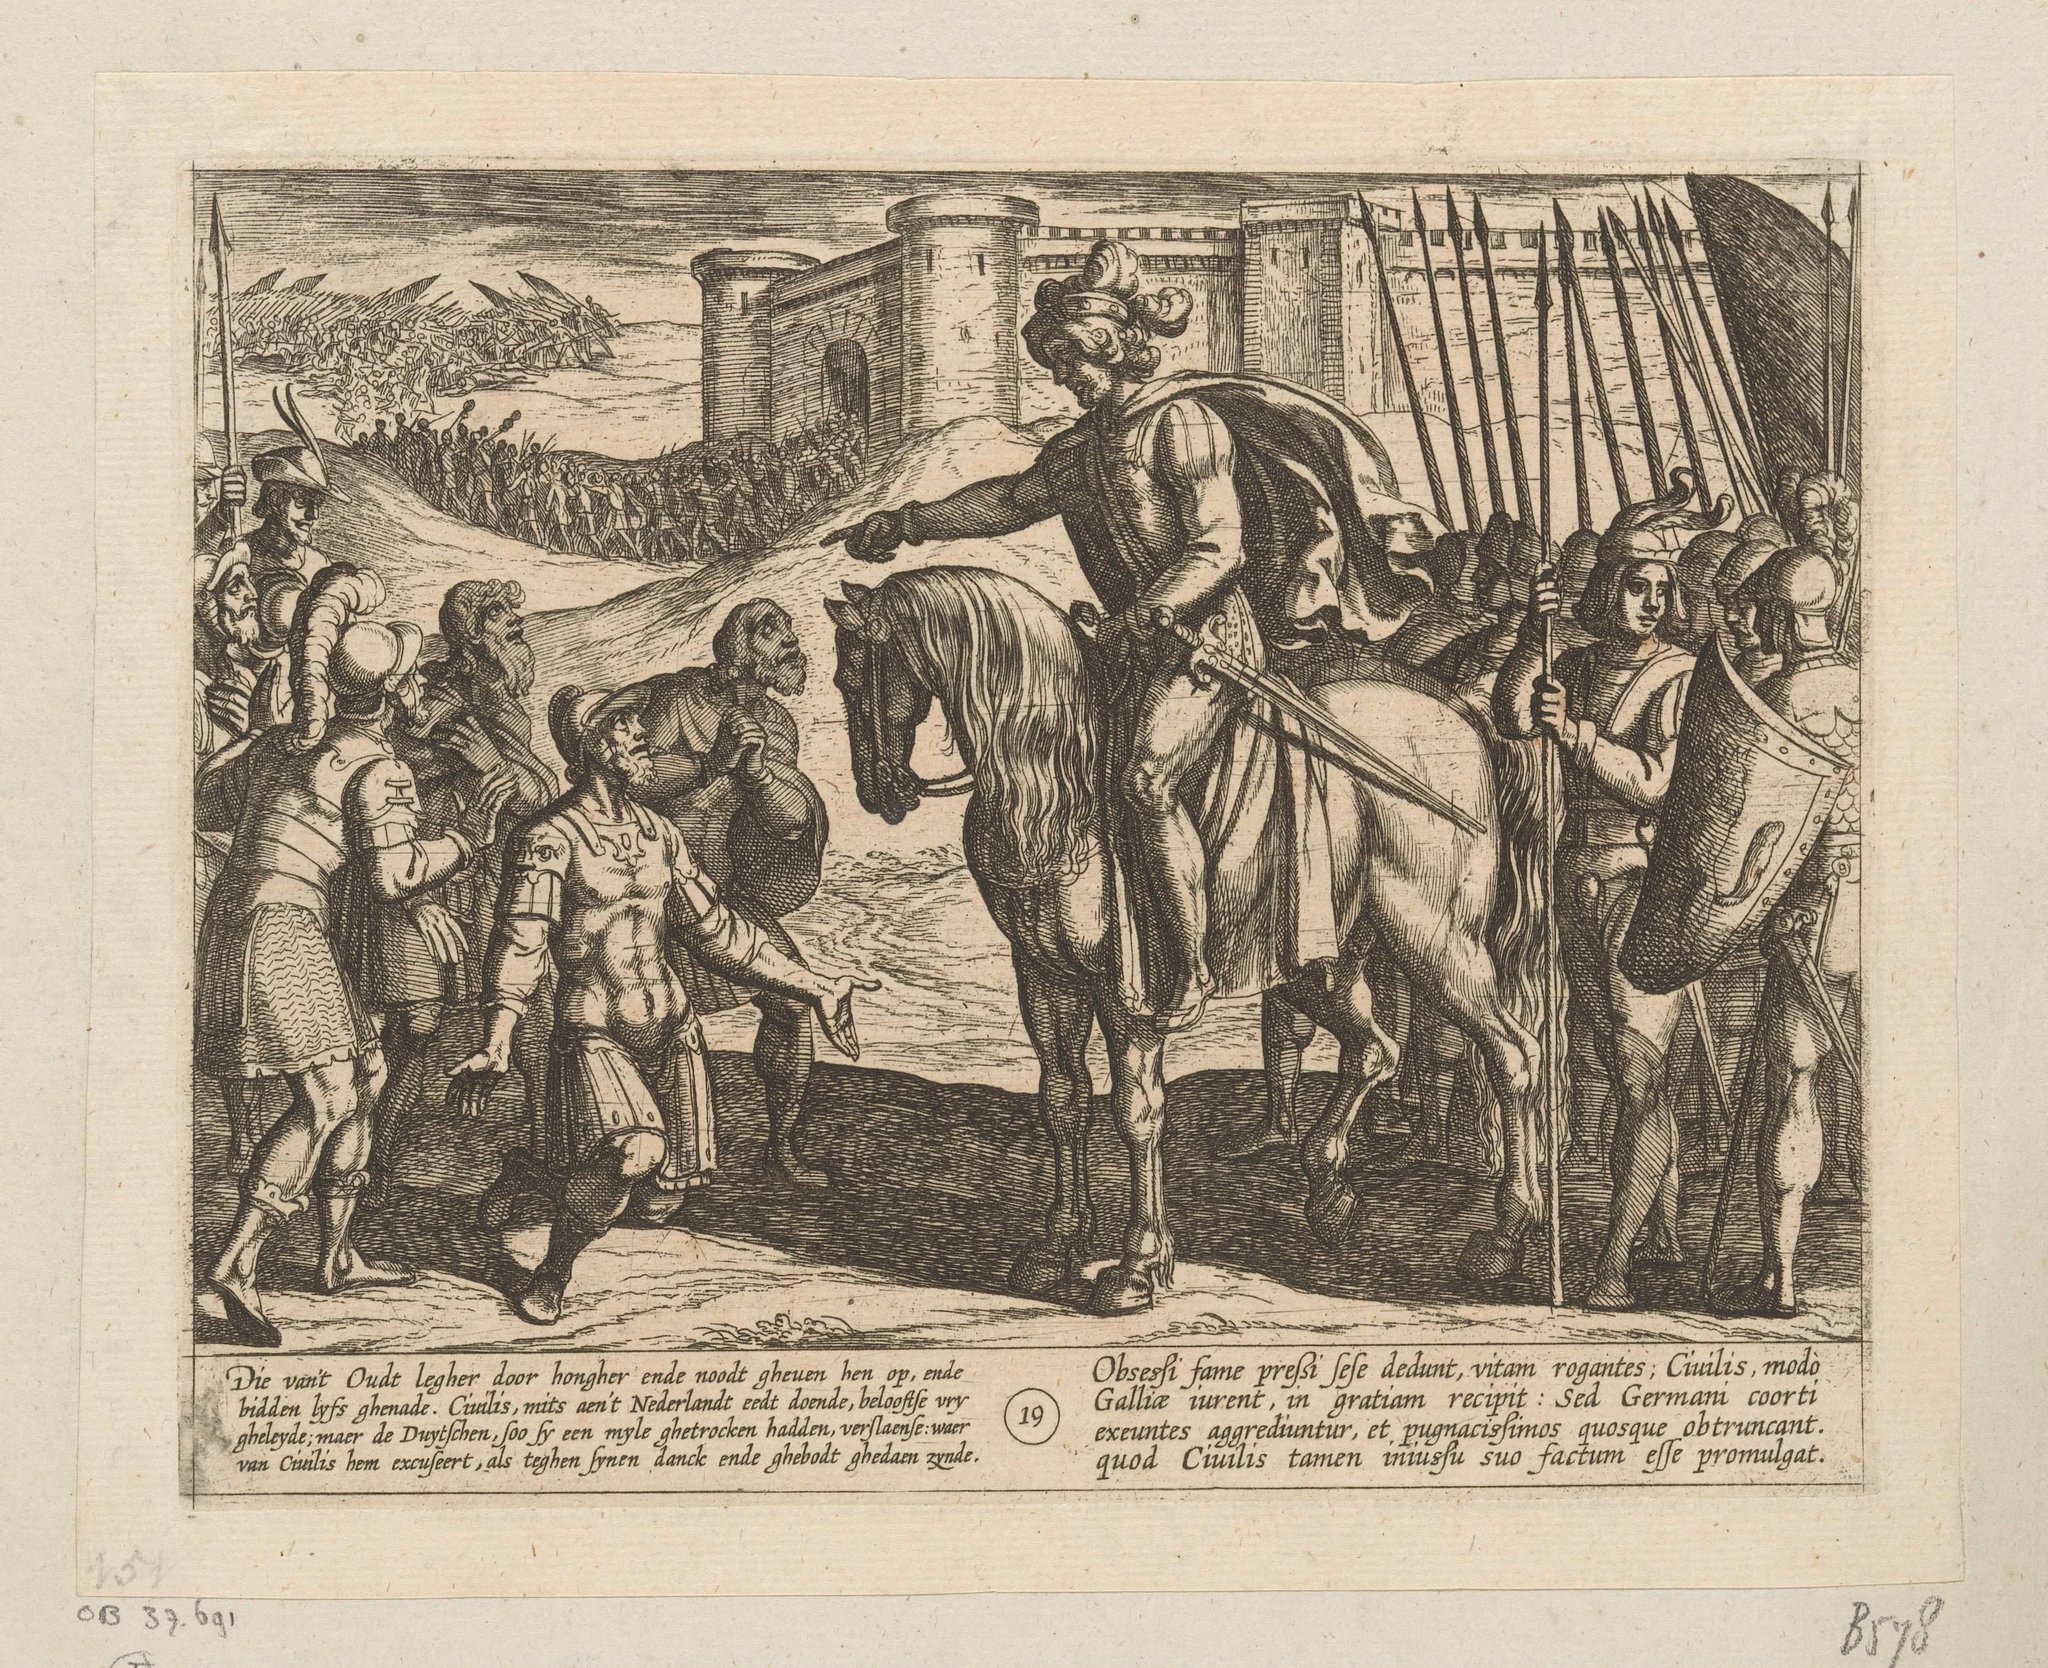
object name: print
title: De Bataafse Opstand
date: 1612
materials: paper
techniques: etching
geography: italy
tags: battle, fighting in general, extinct, 'historical' peoples (with name), netherlands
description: Uitgeputte Romeinse soldaten smeken Civilis om genade. Civilis gezeten op een paar schenkt hun genade mits zij in een eed trouw zweren aan Nederland. Prent nummer 19 in de serie prenten over de Bataafse Opstand: Batavorum cum Romanis bellum / à Corn. Tacito lib. IV & V. : Hist. olim descriptum, figuris nunc aeneis expressum, auctore Othone Vaenio Lugdunobatava = De Batavische oft oude Hollandtsche oorloghe teghen de Romeynen. Otto Vaenius, Antwerpen 1612. Onderaan twee verzen van vier regels in het Nederlands en in het Latijn. Zonder tekst op achterzijde.